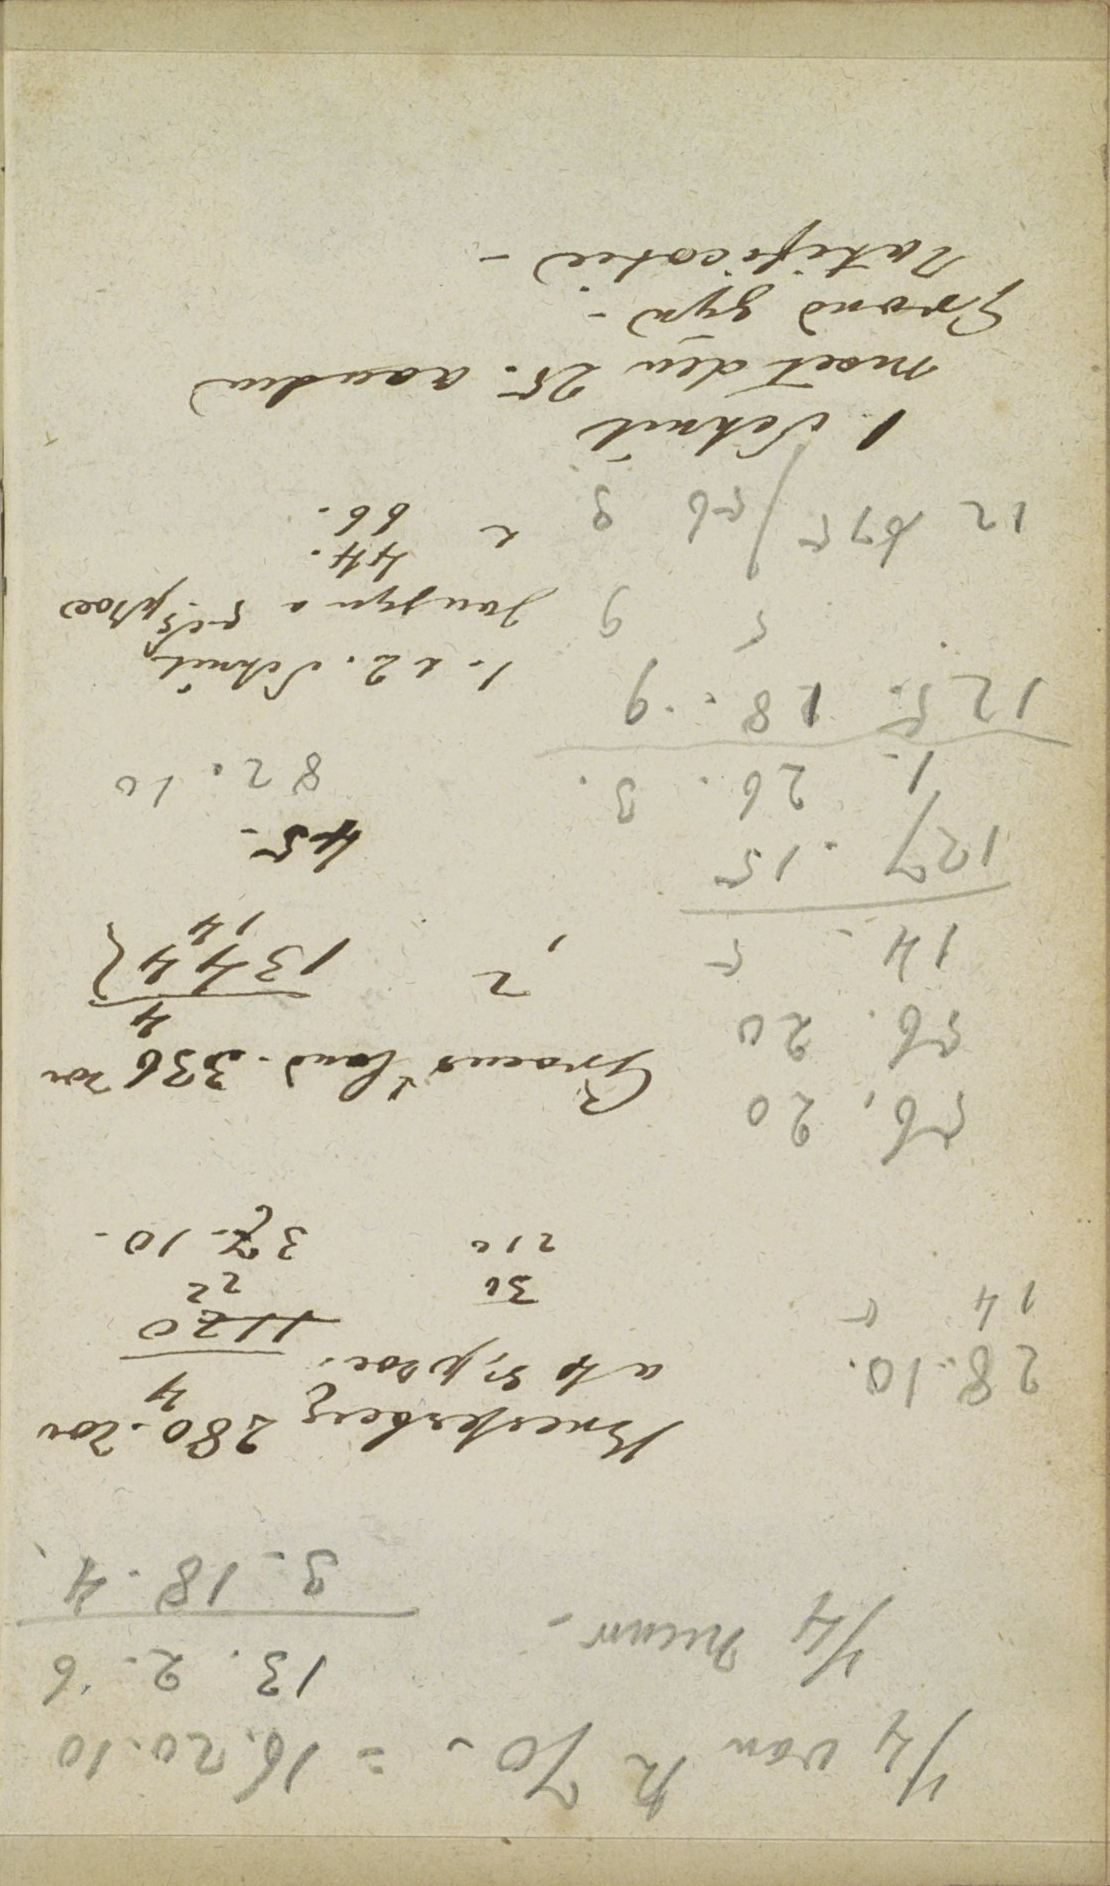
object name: sketchbook leaf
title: Aantekeningen over landbouw en berekeningen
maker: johannes tavenraat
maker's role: draughtsman, painter, print maker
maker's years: 1809-1881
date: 1854-1868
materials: ink, paper, pencil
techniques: pen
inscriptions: annotation: ‘[...]’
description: Blad 83 recto uit een schetsboek met 88 bladen.